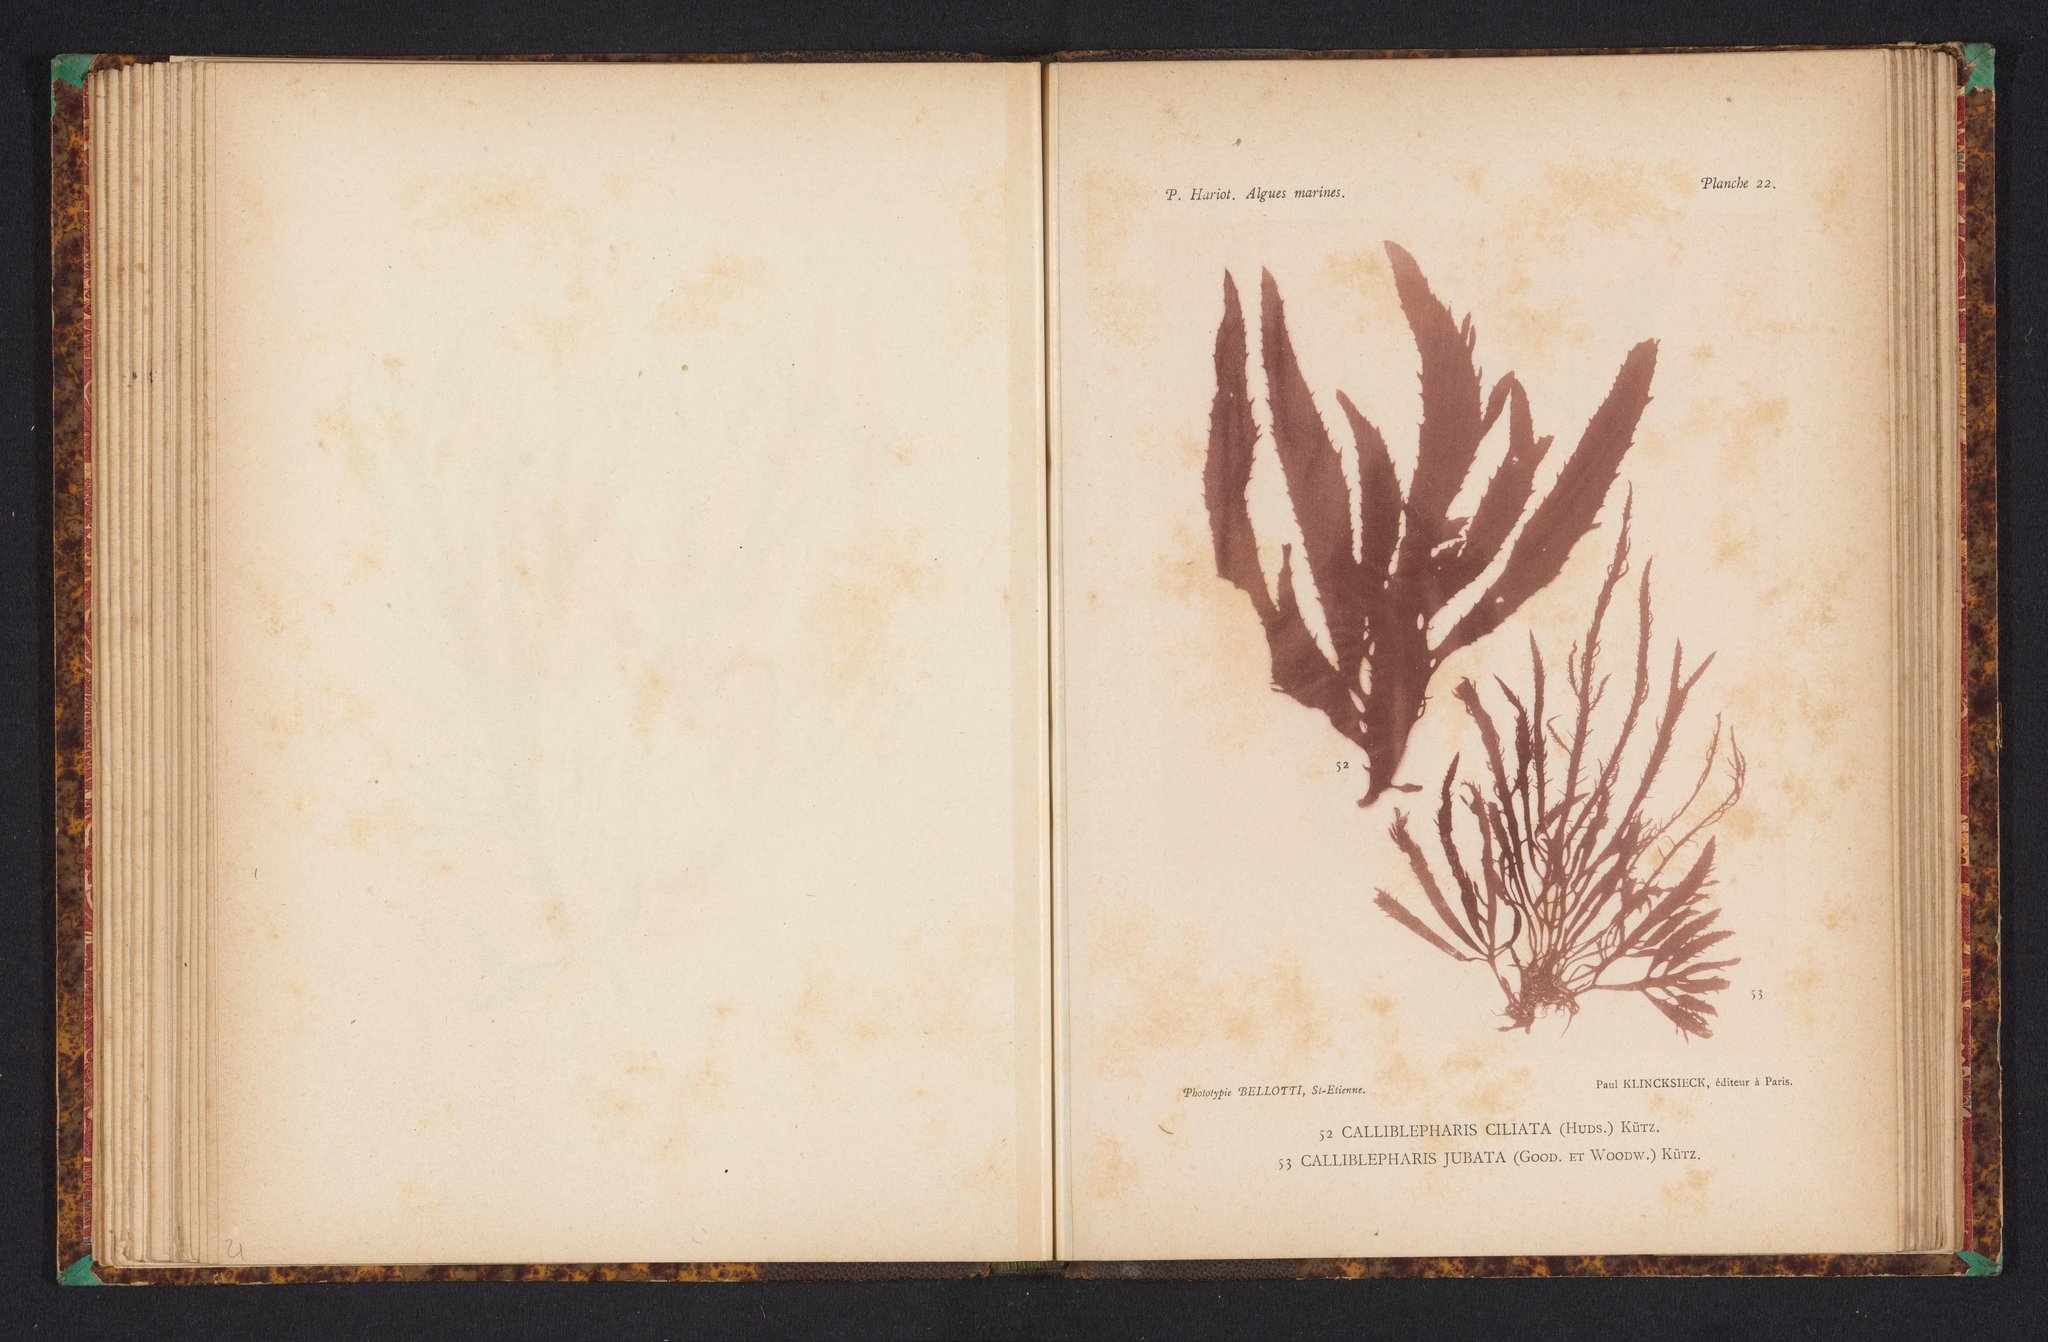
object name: page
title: Twee soorten zeewier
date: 1882-1892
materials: paper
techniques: photograph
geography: saint-étienne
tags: algae, seaweed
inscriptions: inscription: ‘Calliblepharis (...) jubata (Good. et Woodw.) Kütz.’, number: ‘52 (...) 53’, number: ‘Planche 22.’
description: (52) is Calliblepharis ciliata, (53) is Calliblepharis jubata.